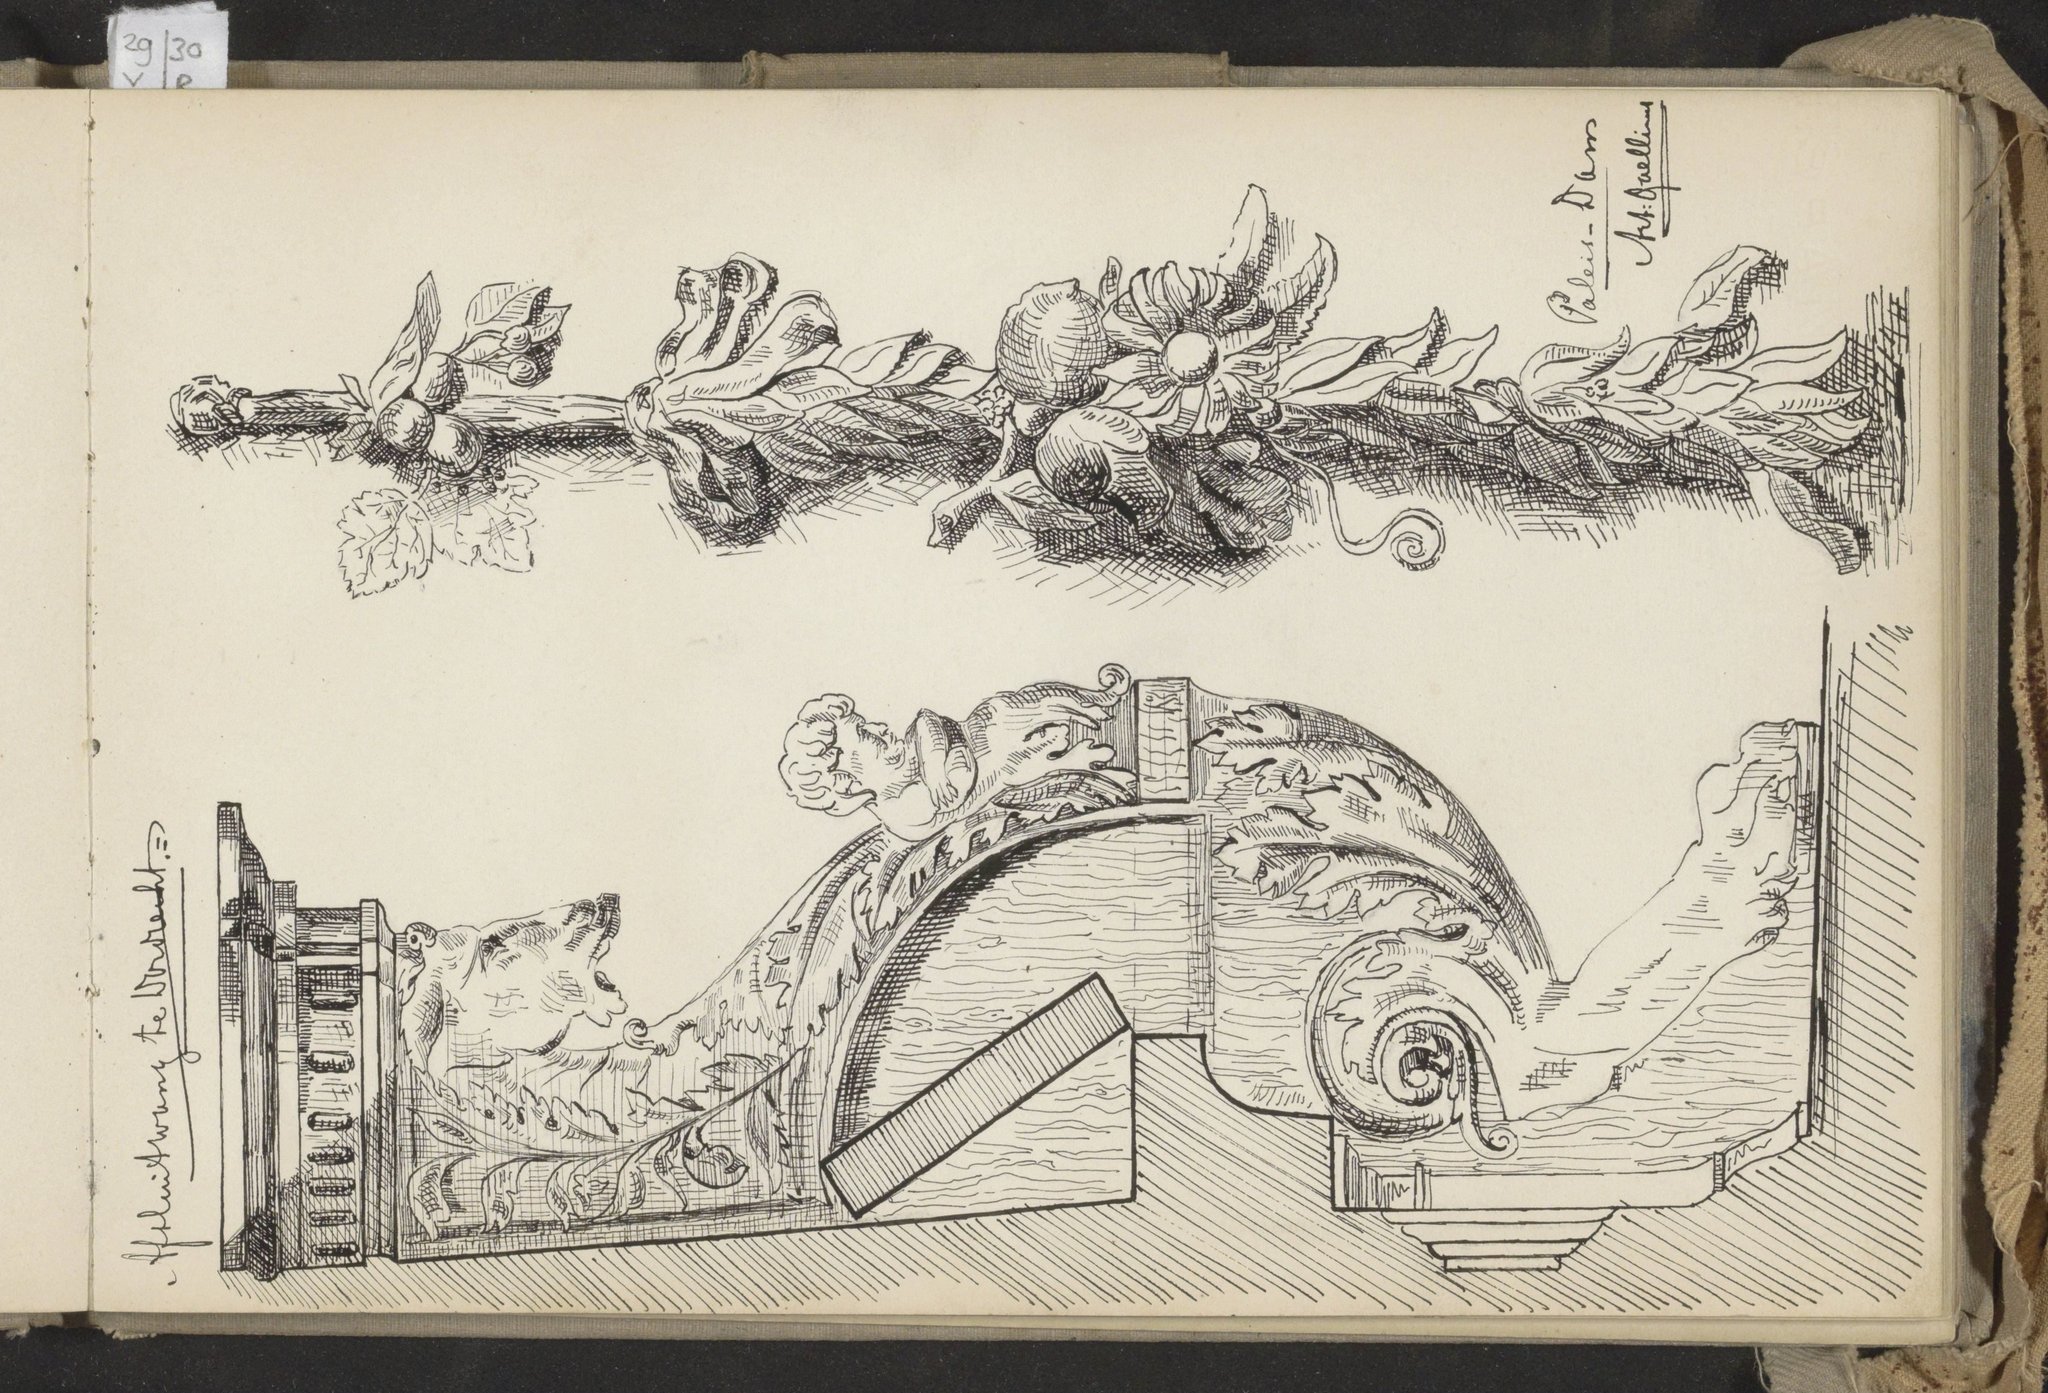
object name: sketchbook leaf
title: Houtsnijwerk van een afsluitwand in de Grote Kerk te Dordrecht en ornamenteel beeldhouwwerk uit het Paleis op de Dam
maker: johanna van de kamer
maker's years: 1873-1922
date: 1890-1922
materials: ink, paper, pencil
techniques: pen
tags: carving ~ applied arts, sculpture, royal palace of amsterdam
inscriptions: annotation: ‘afsluitwand te Dordrecht/ Paleis-Dam/ art: quellinus’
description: Blad 26 recto uit een schetsboek met 49 bladen.